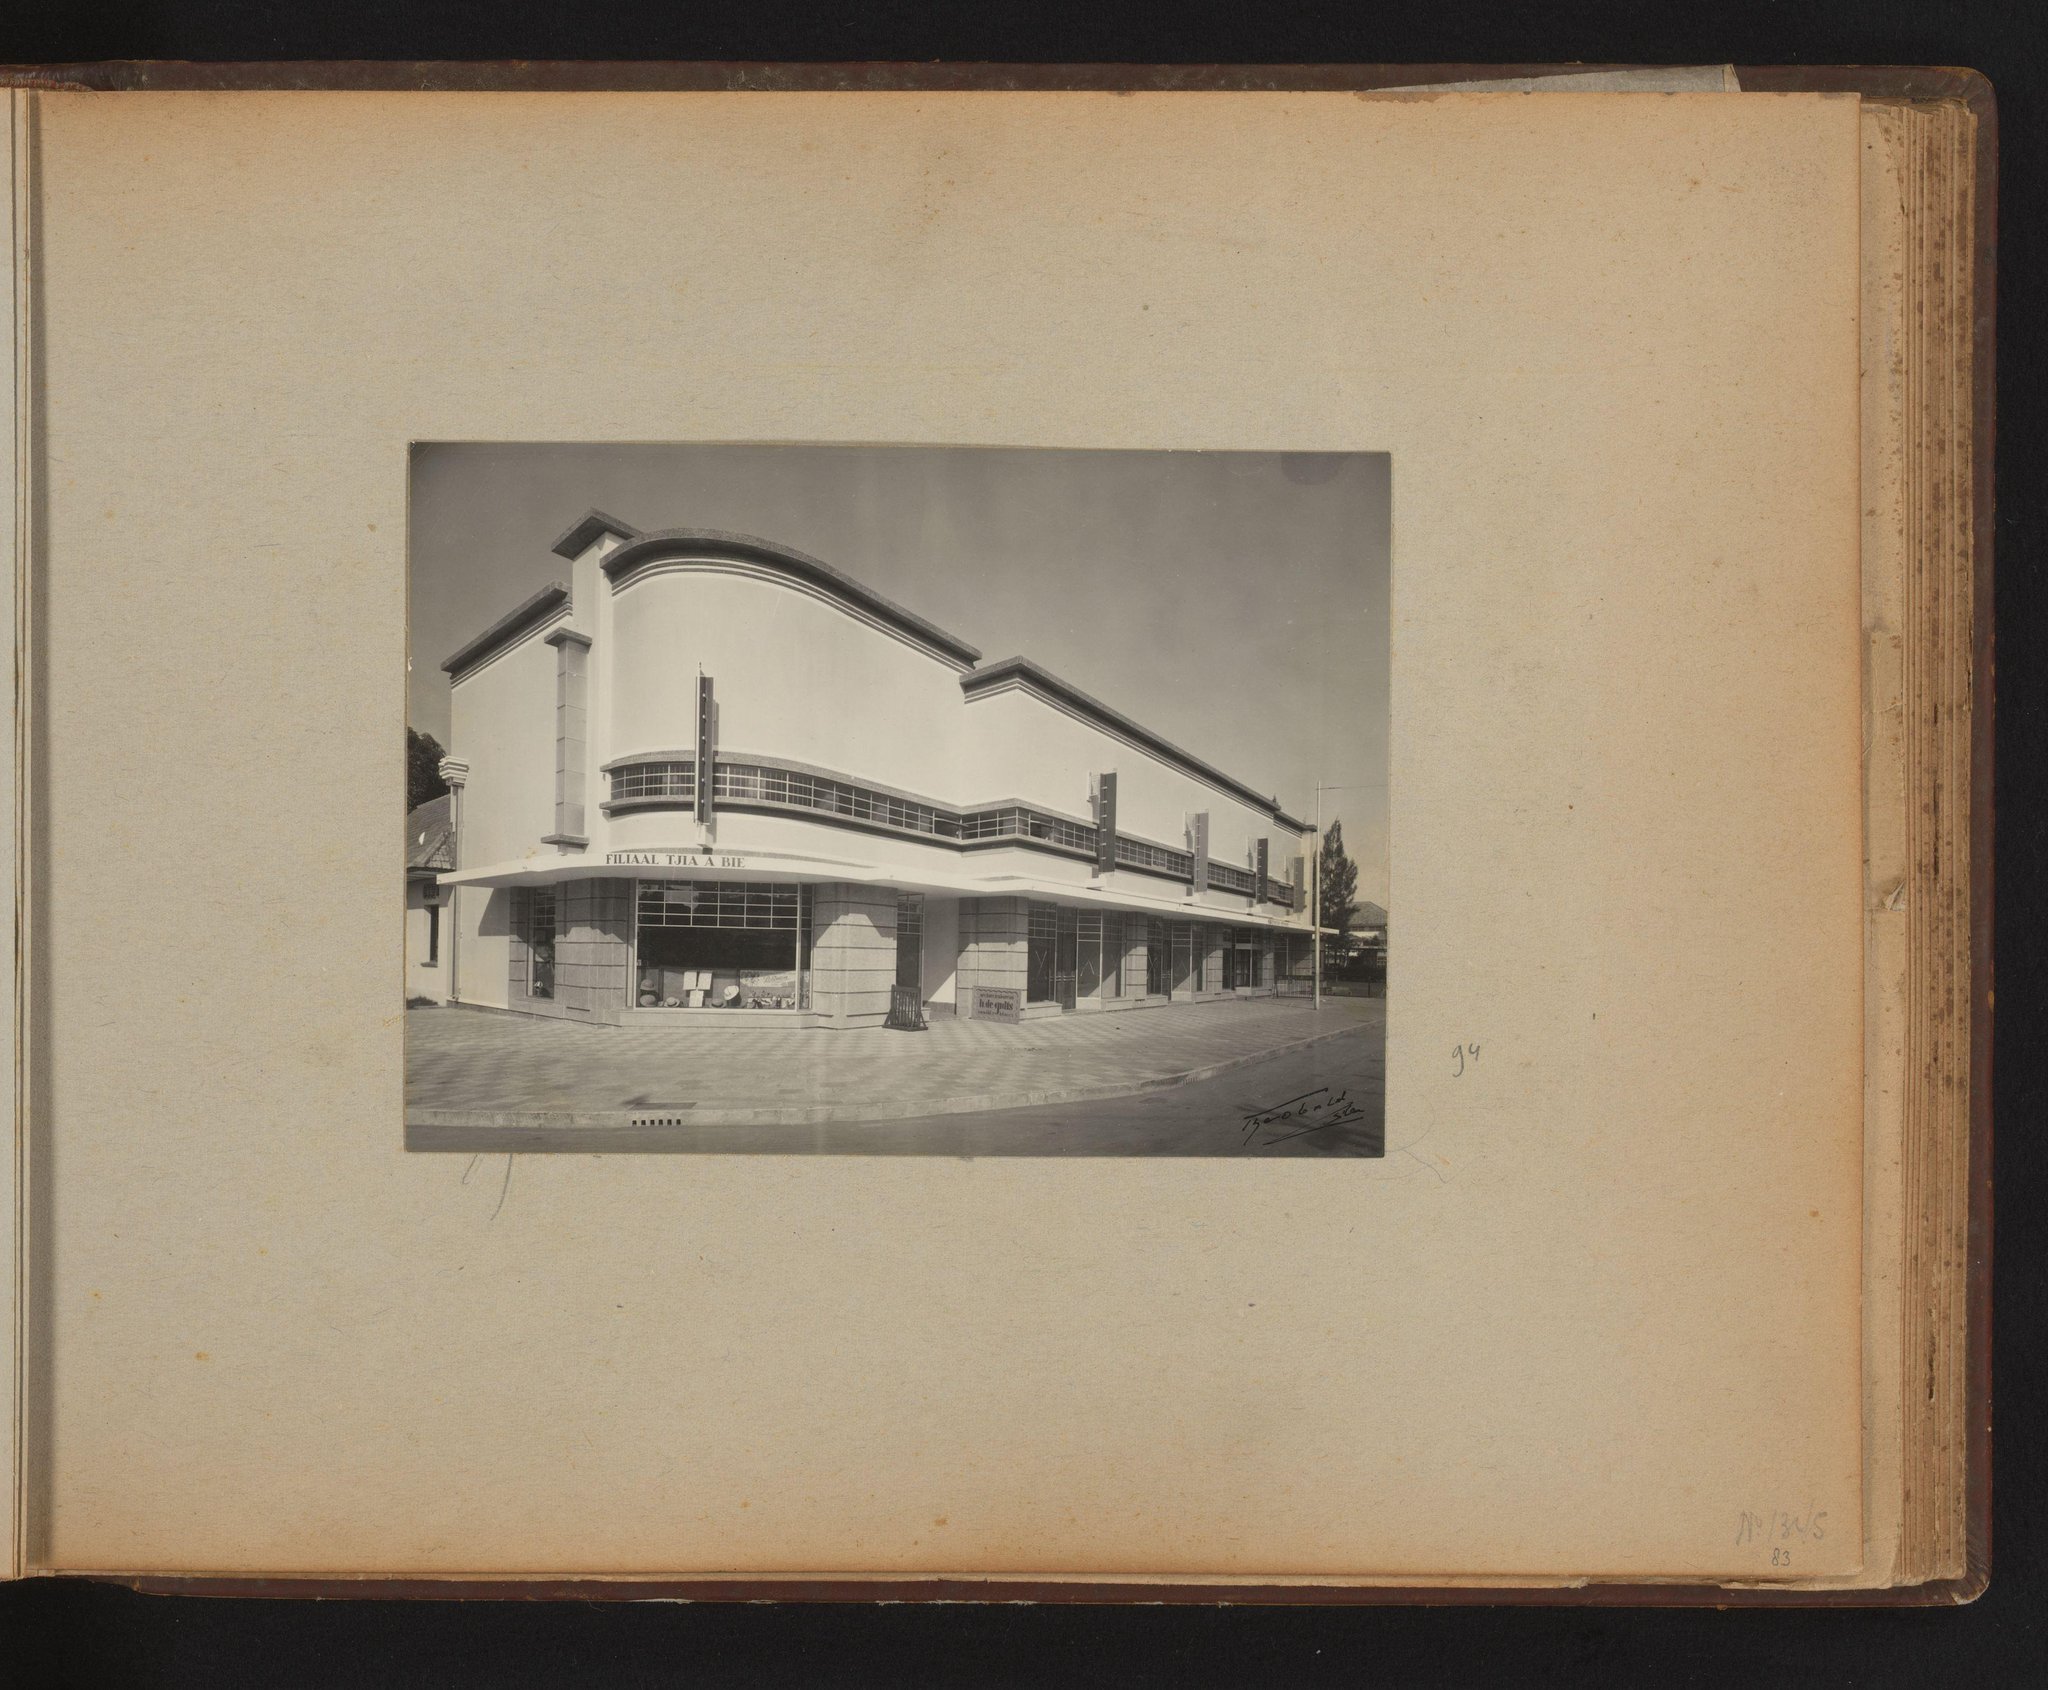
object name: album leaf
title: Kledingzaak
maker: Anonymous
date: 1931-1937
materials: cardboard, photographic support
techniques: gelatin silver print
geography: surabaya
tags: shop, store, street, edifice, e.g.: public building, department store, surabaya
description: Albumblad met een foto van de straatgevel van een nieuw opgeleverd gebouw, waarin een filiaal van de kledingzaak Tjia A Bie. Bij de ingang een bord met de naam van het architectenbureau H. de Gidts te Soerabaja. Onderdeel van een fotoalbum met foto's van machines en constructies van de N.V. Machinefabriek Braat te Soerabaja, Soekaboemi en Tegal uit de periode 1931-1937.